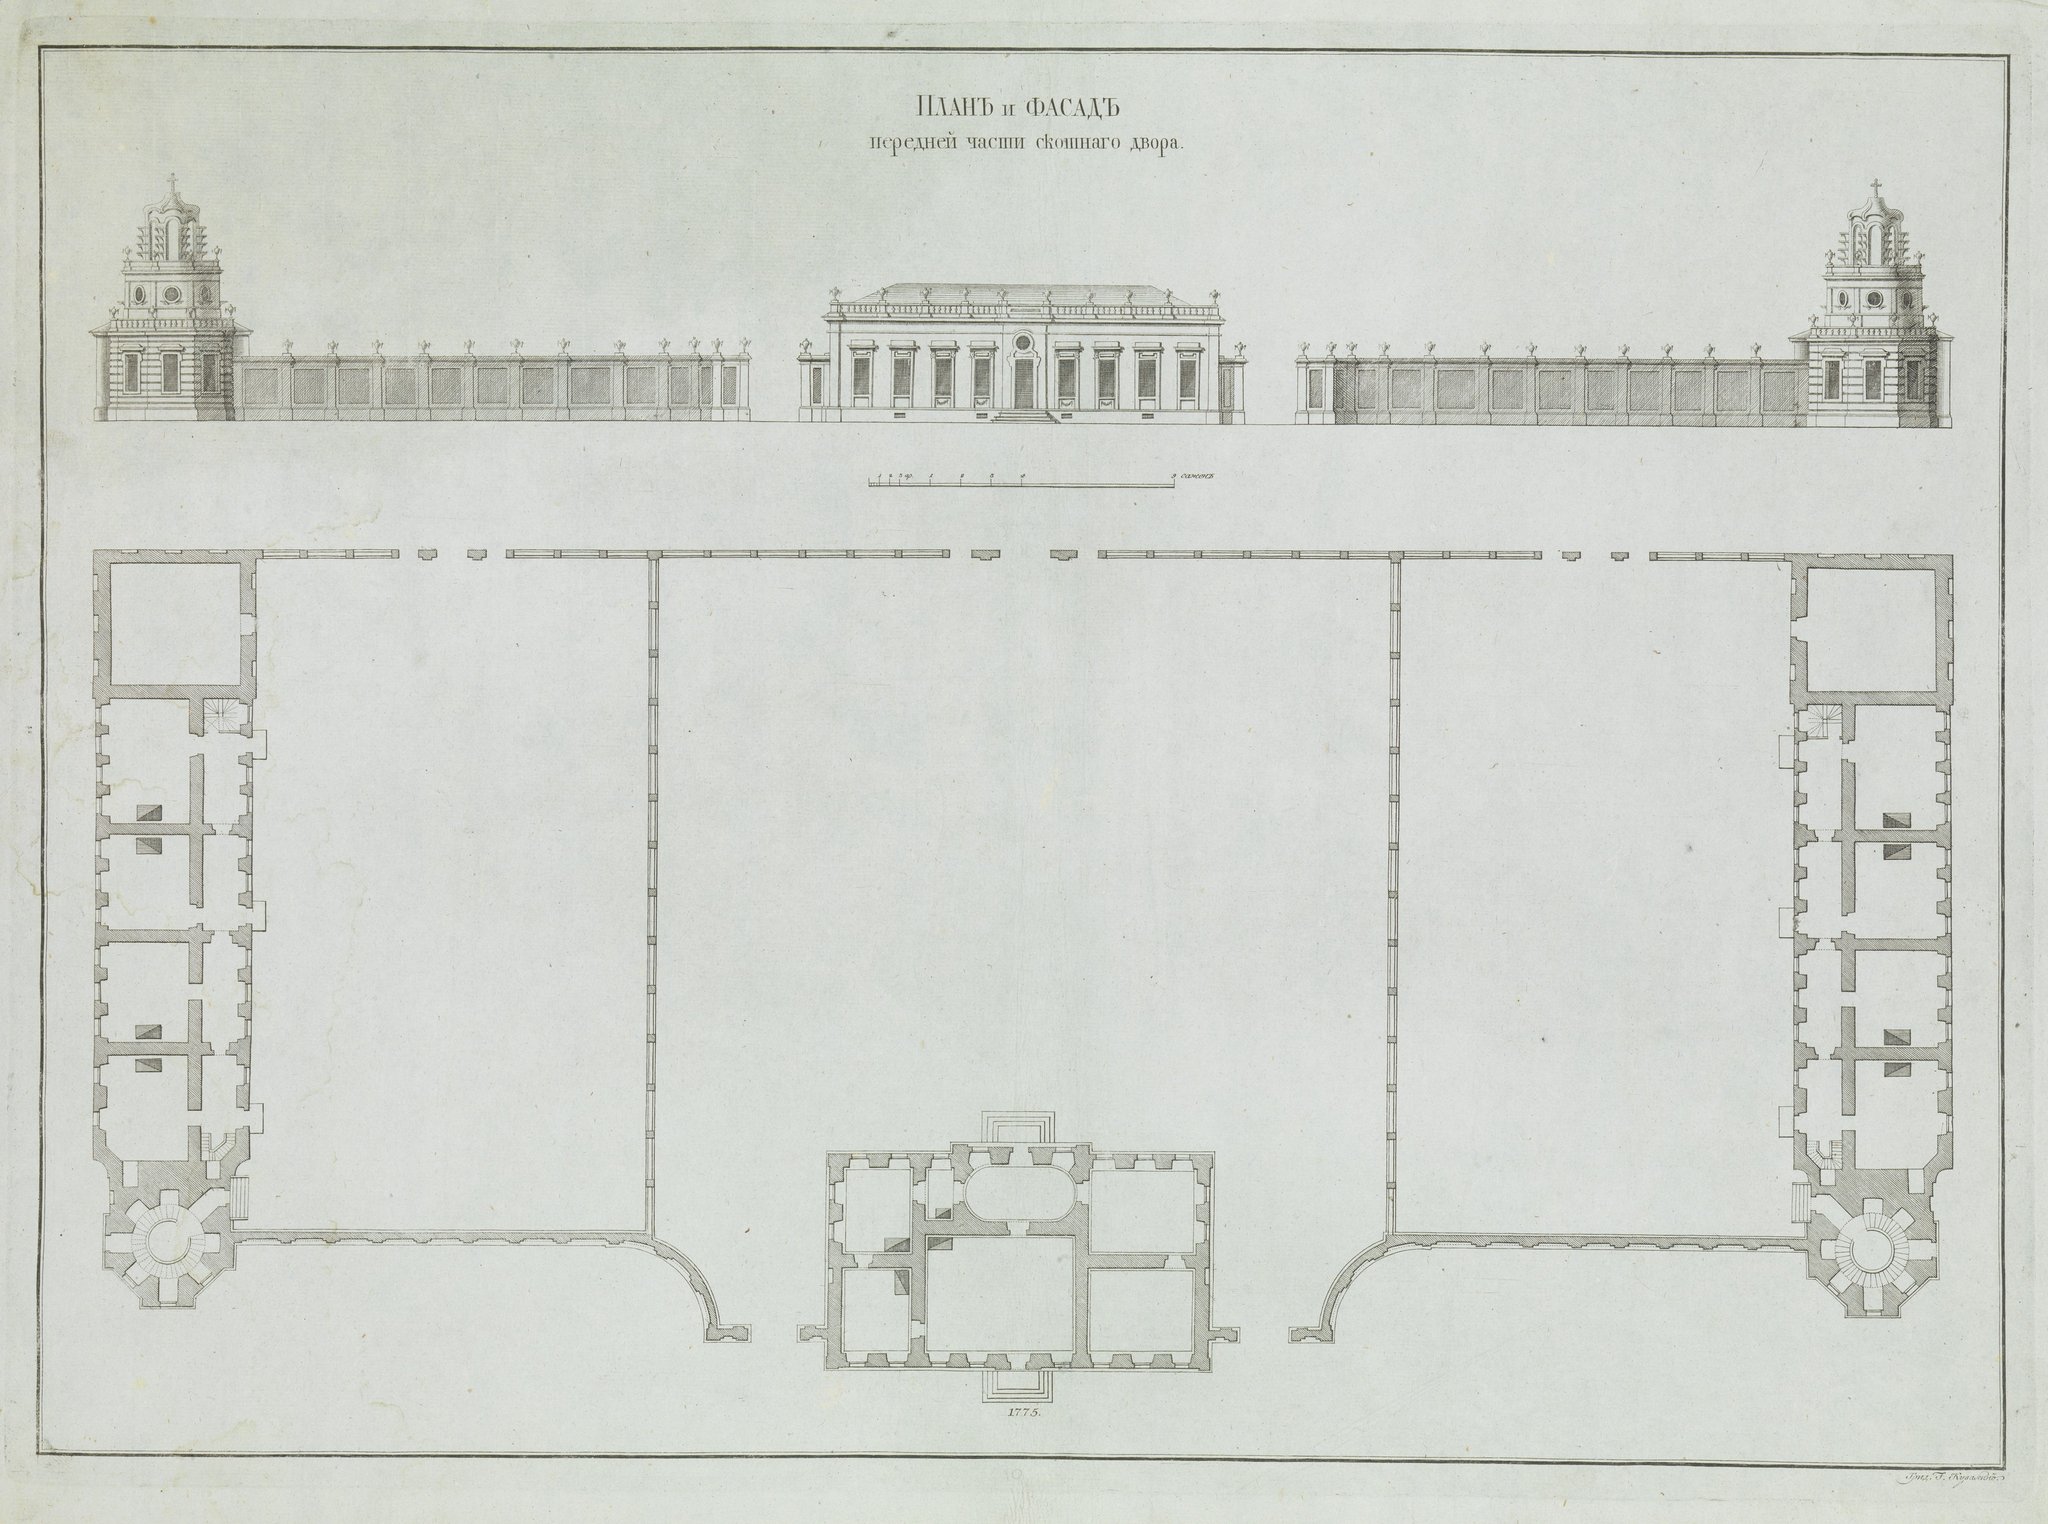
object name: print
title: Elevation and Plan of a Small Building, from "Russian Palaces and Gardens"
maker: ivan kuvakin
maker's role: artist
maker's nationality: russian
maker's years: 1751-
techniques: engraving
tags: architecture